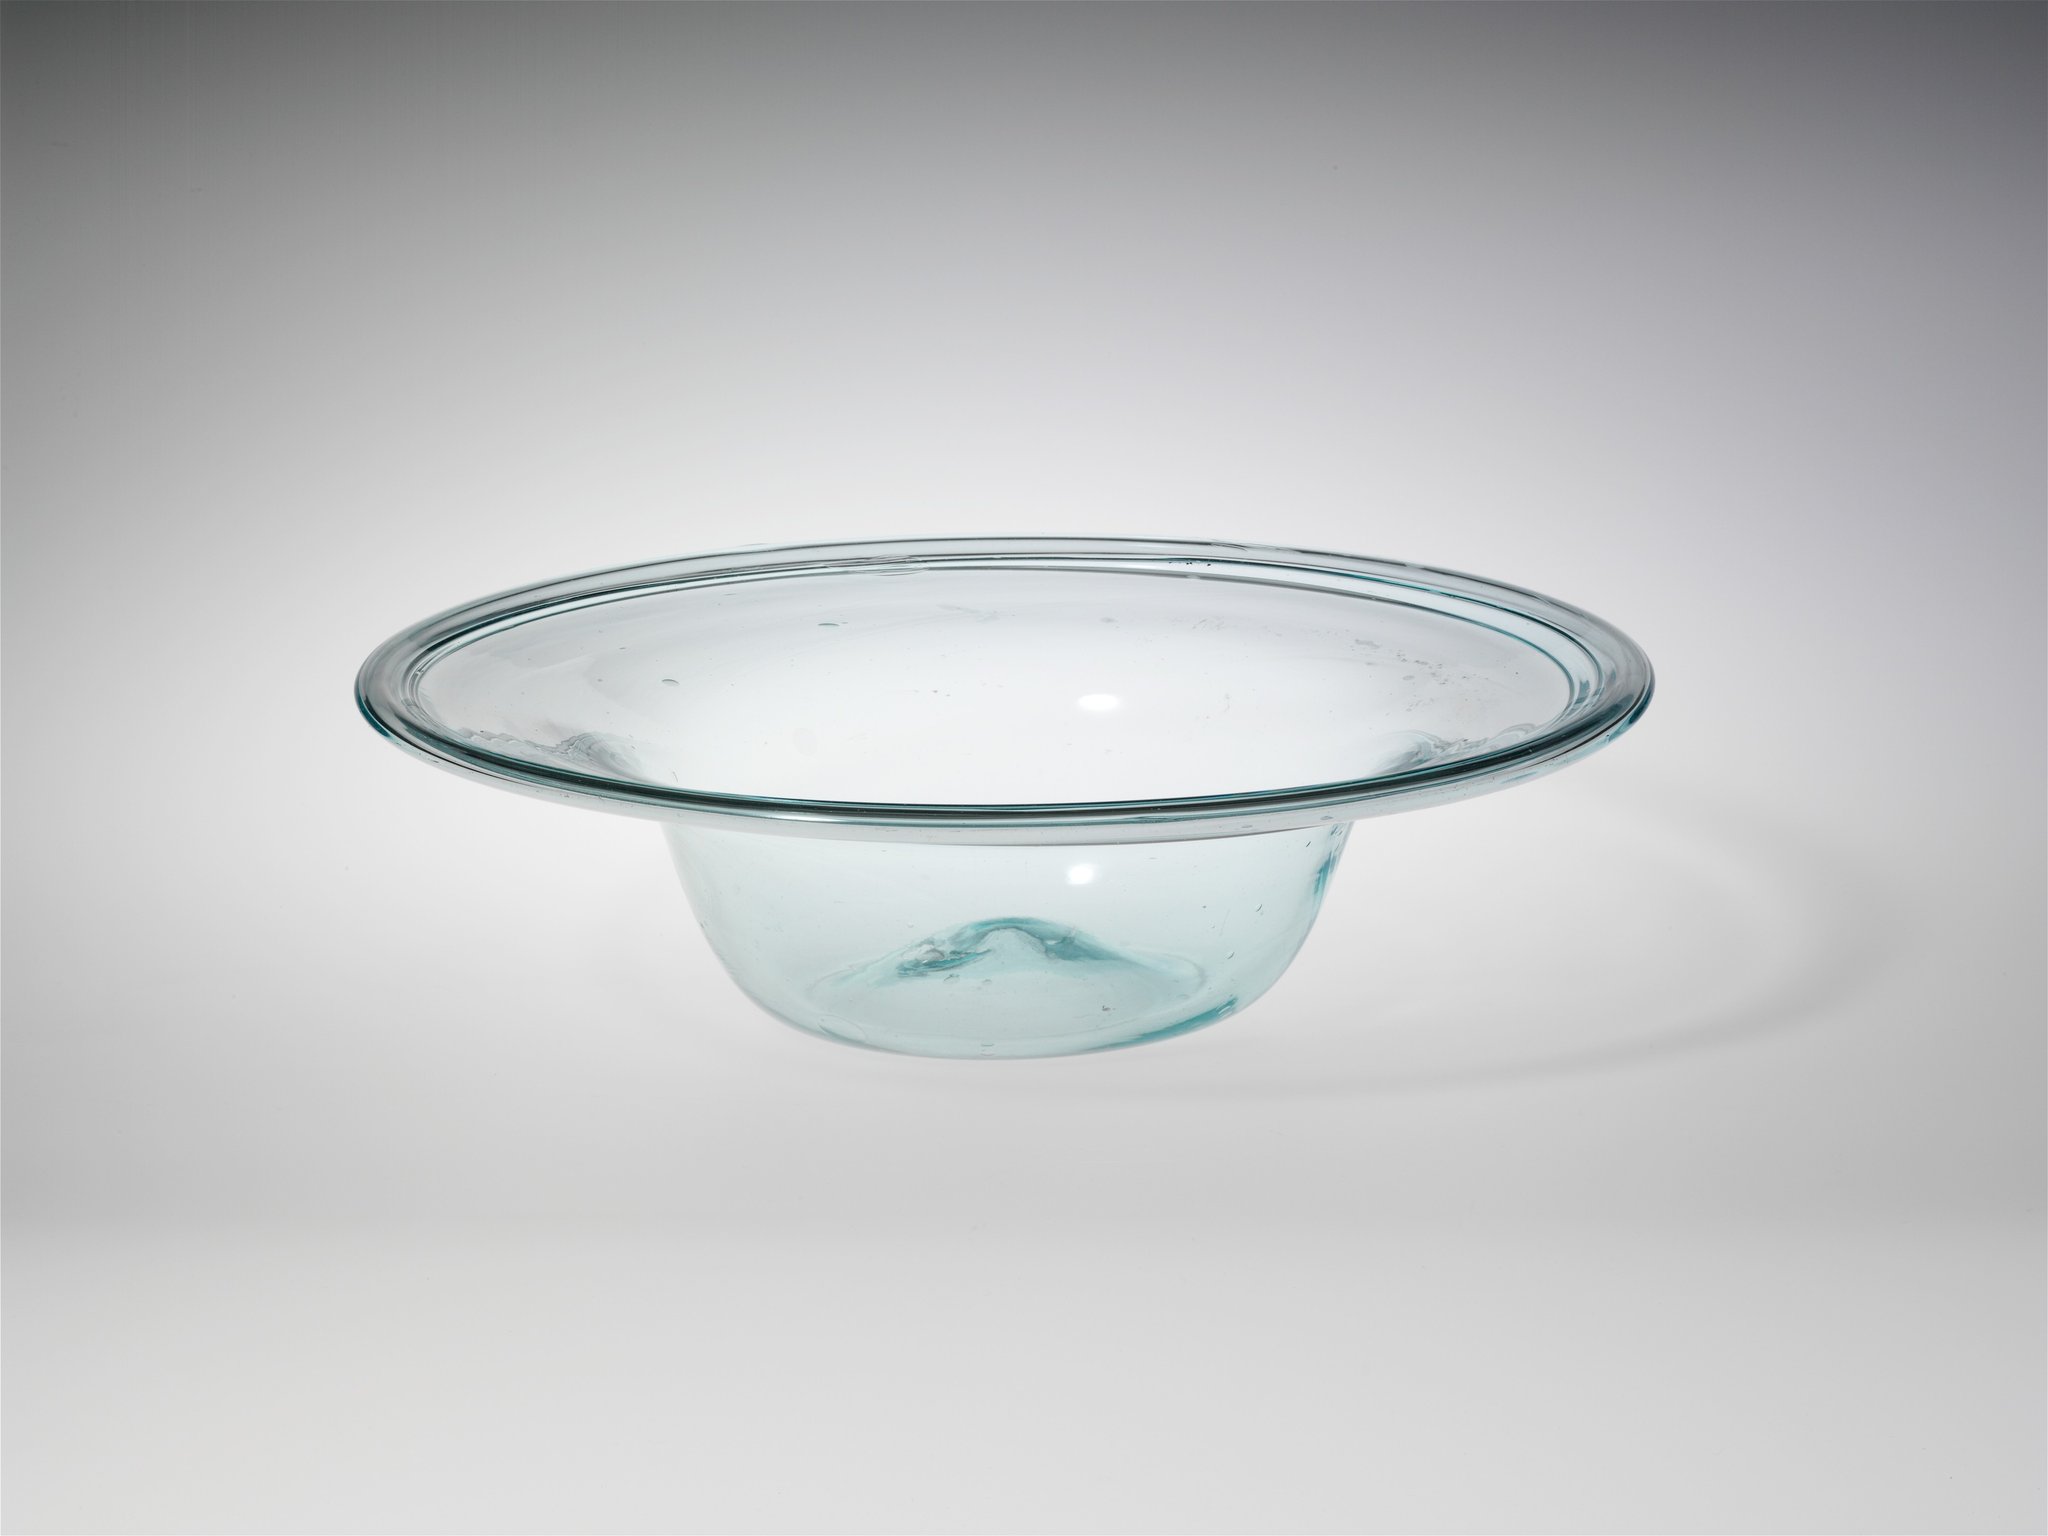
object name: milk bowl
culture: american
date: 1801-1900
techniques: glassblowing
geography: united states